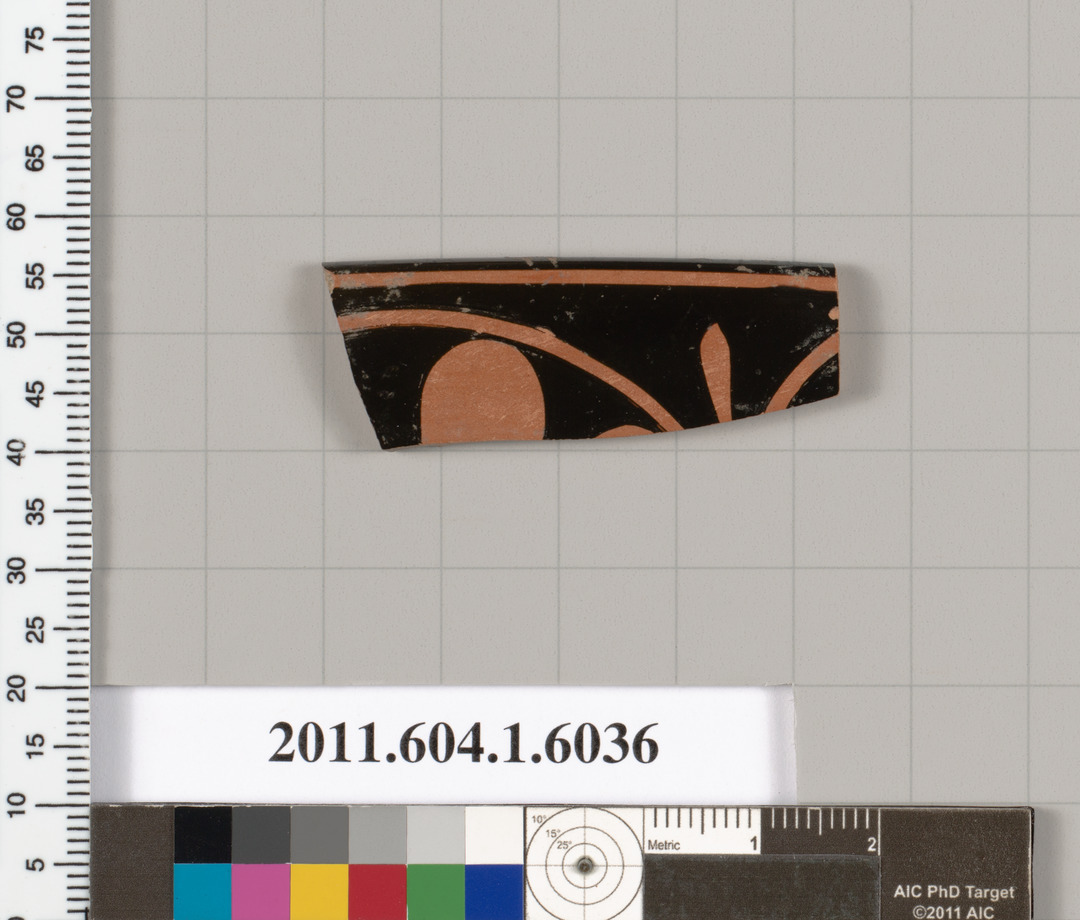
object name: kylix fragment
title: Terracotta rim fragment of a kylix (drinking cup)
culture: greek, attic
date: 510-500 BCE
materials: terracotta